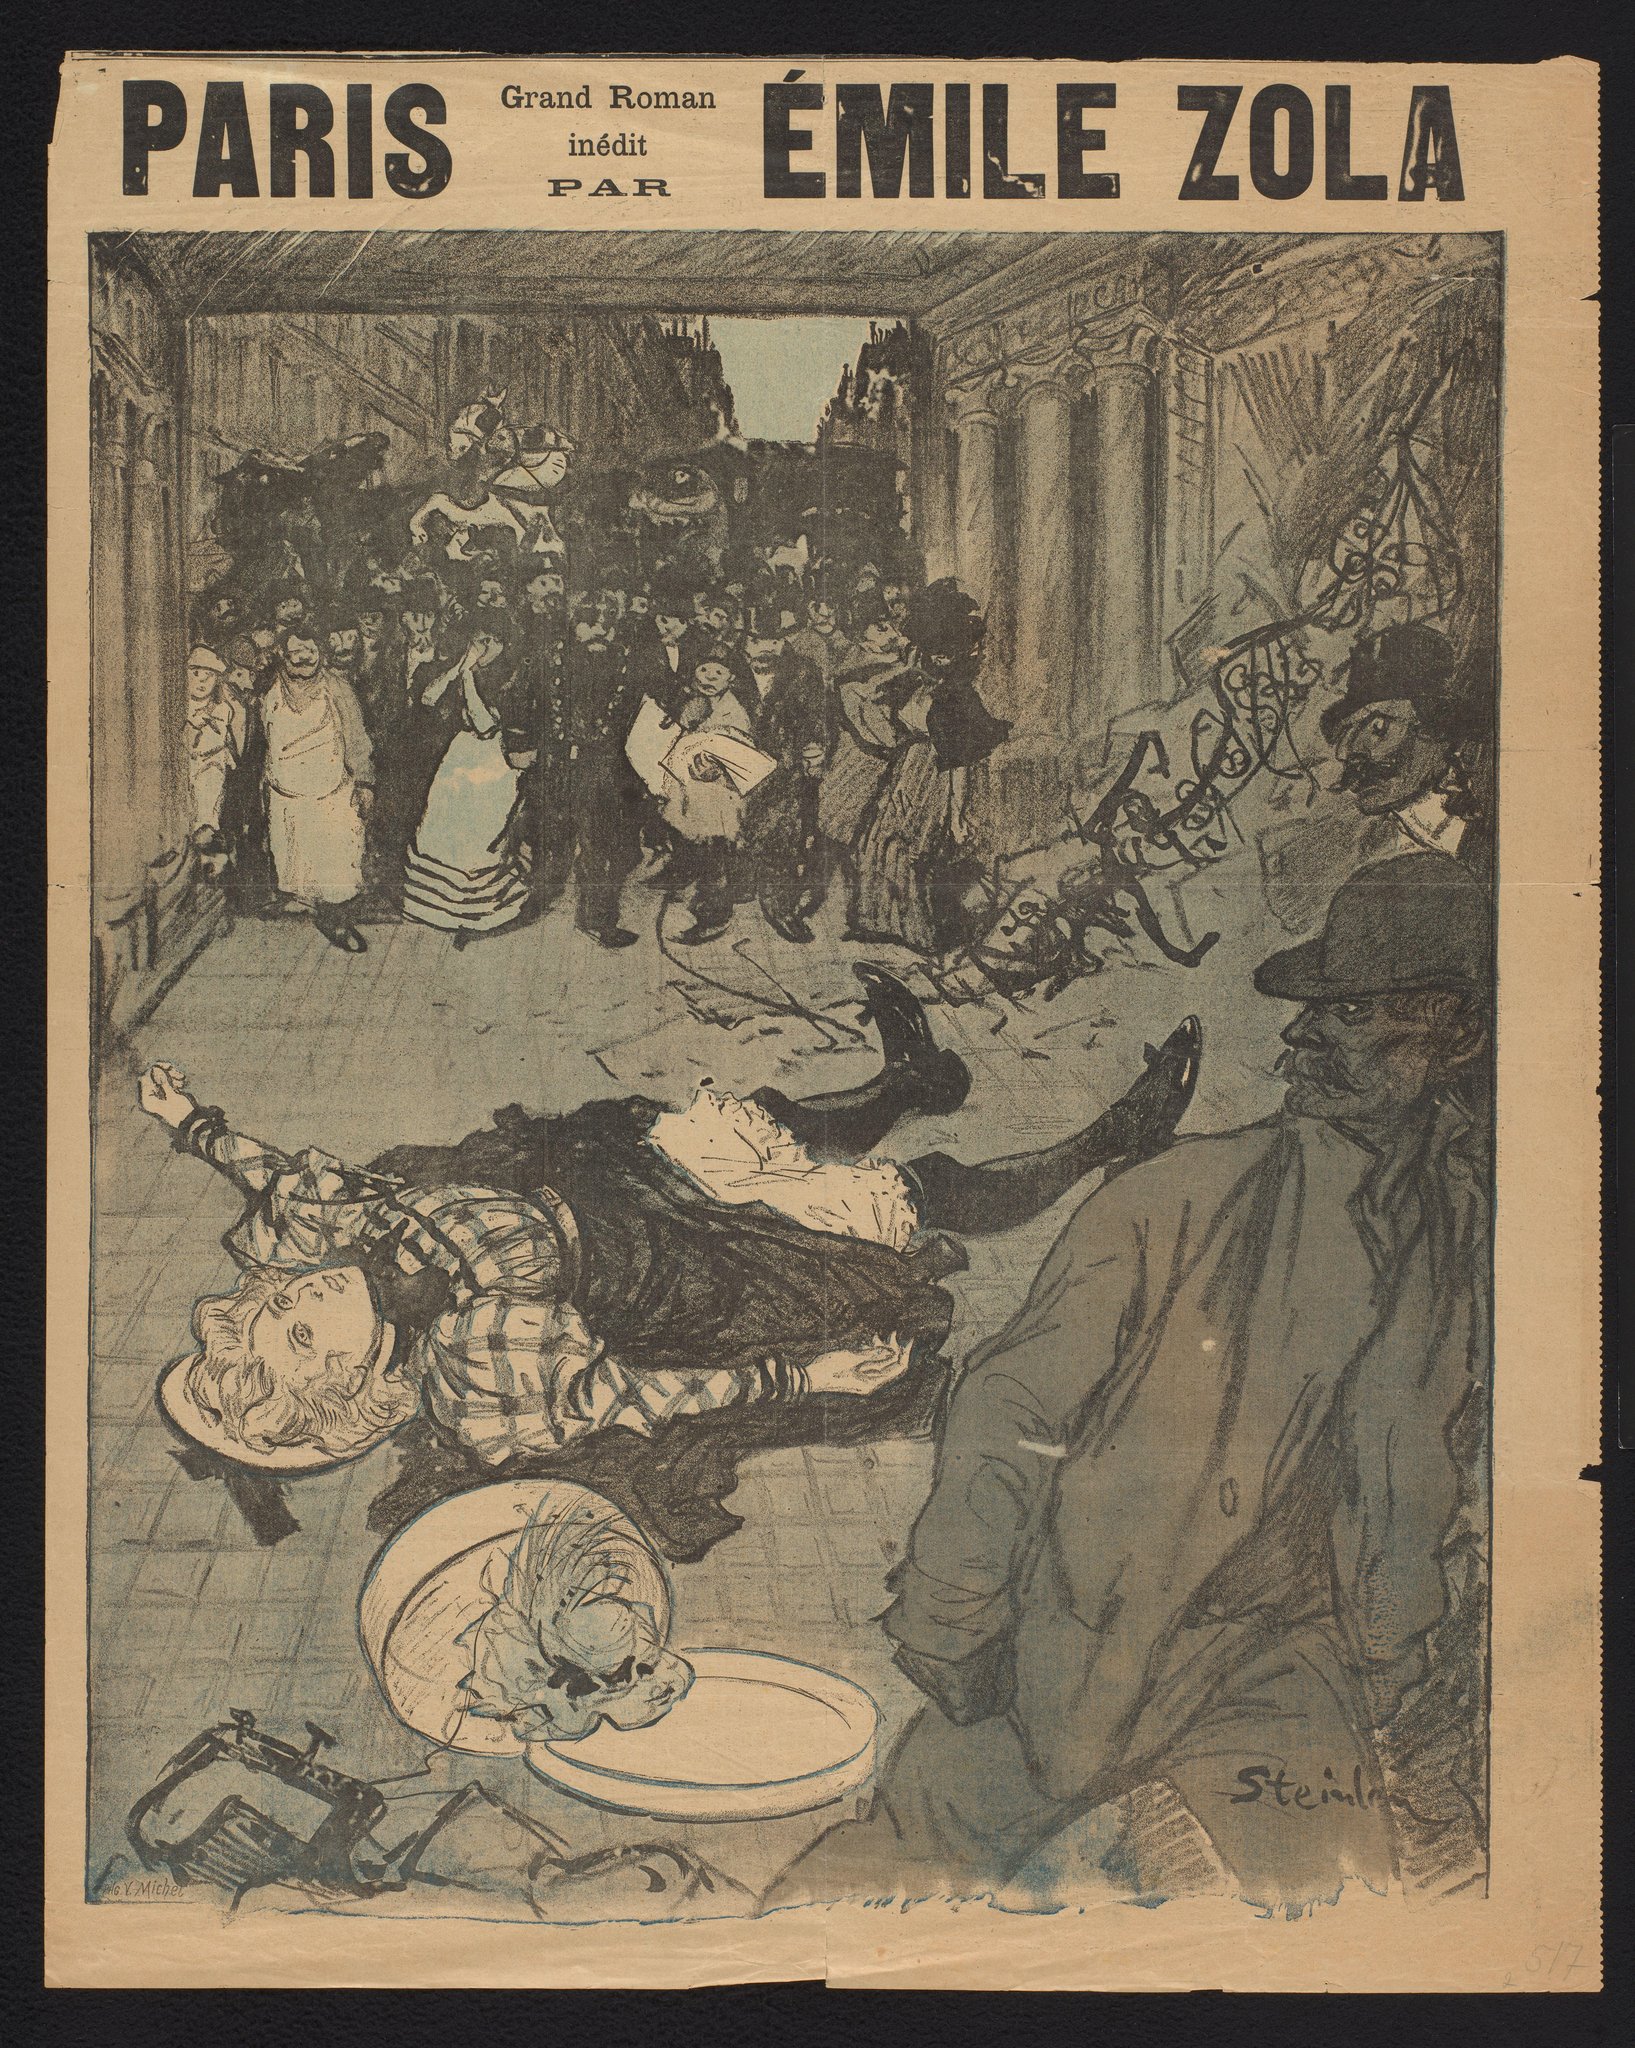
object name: photomechanical print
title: Reclamebiljet voor: Émile Zola, Paris, [1897]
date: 1897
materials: paper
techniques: photograph, letterpress printing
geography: paris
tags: emile zola, finding a dead person, crowd, mob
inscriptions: collector's mark: Lugt 2166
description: Voorpagina van de eerste aflevering van Le Journal (1897) waarin in feuilletonvorm de roman Paris van Émile Zola gedrukt zou worden.